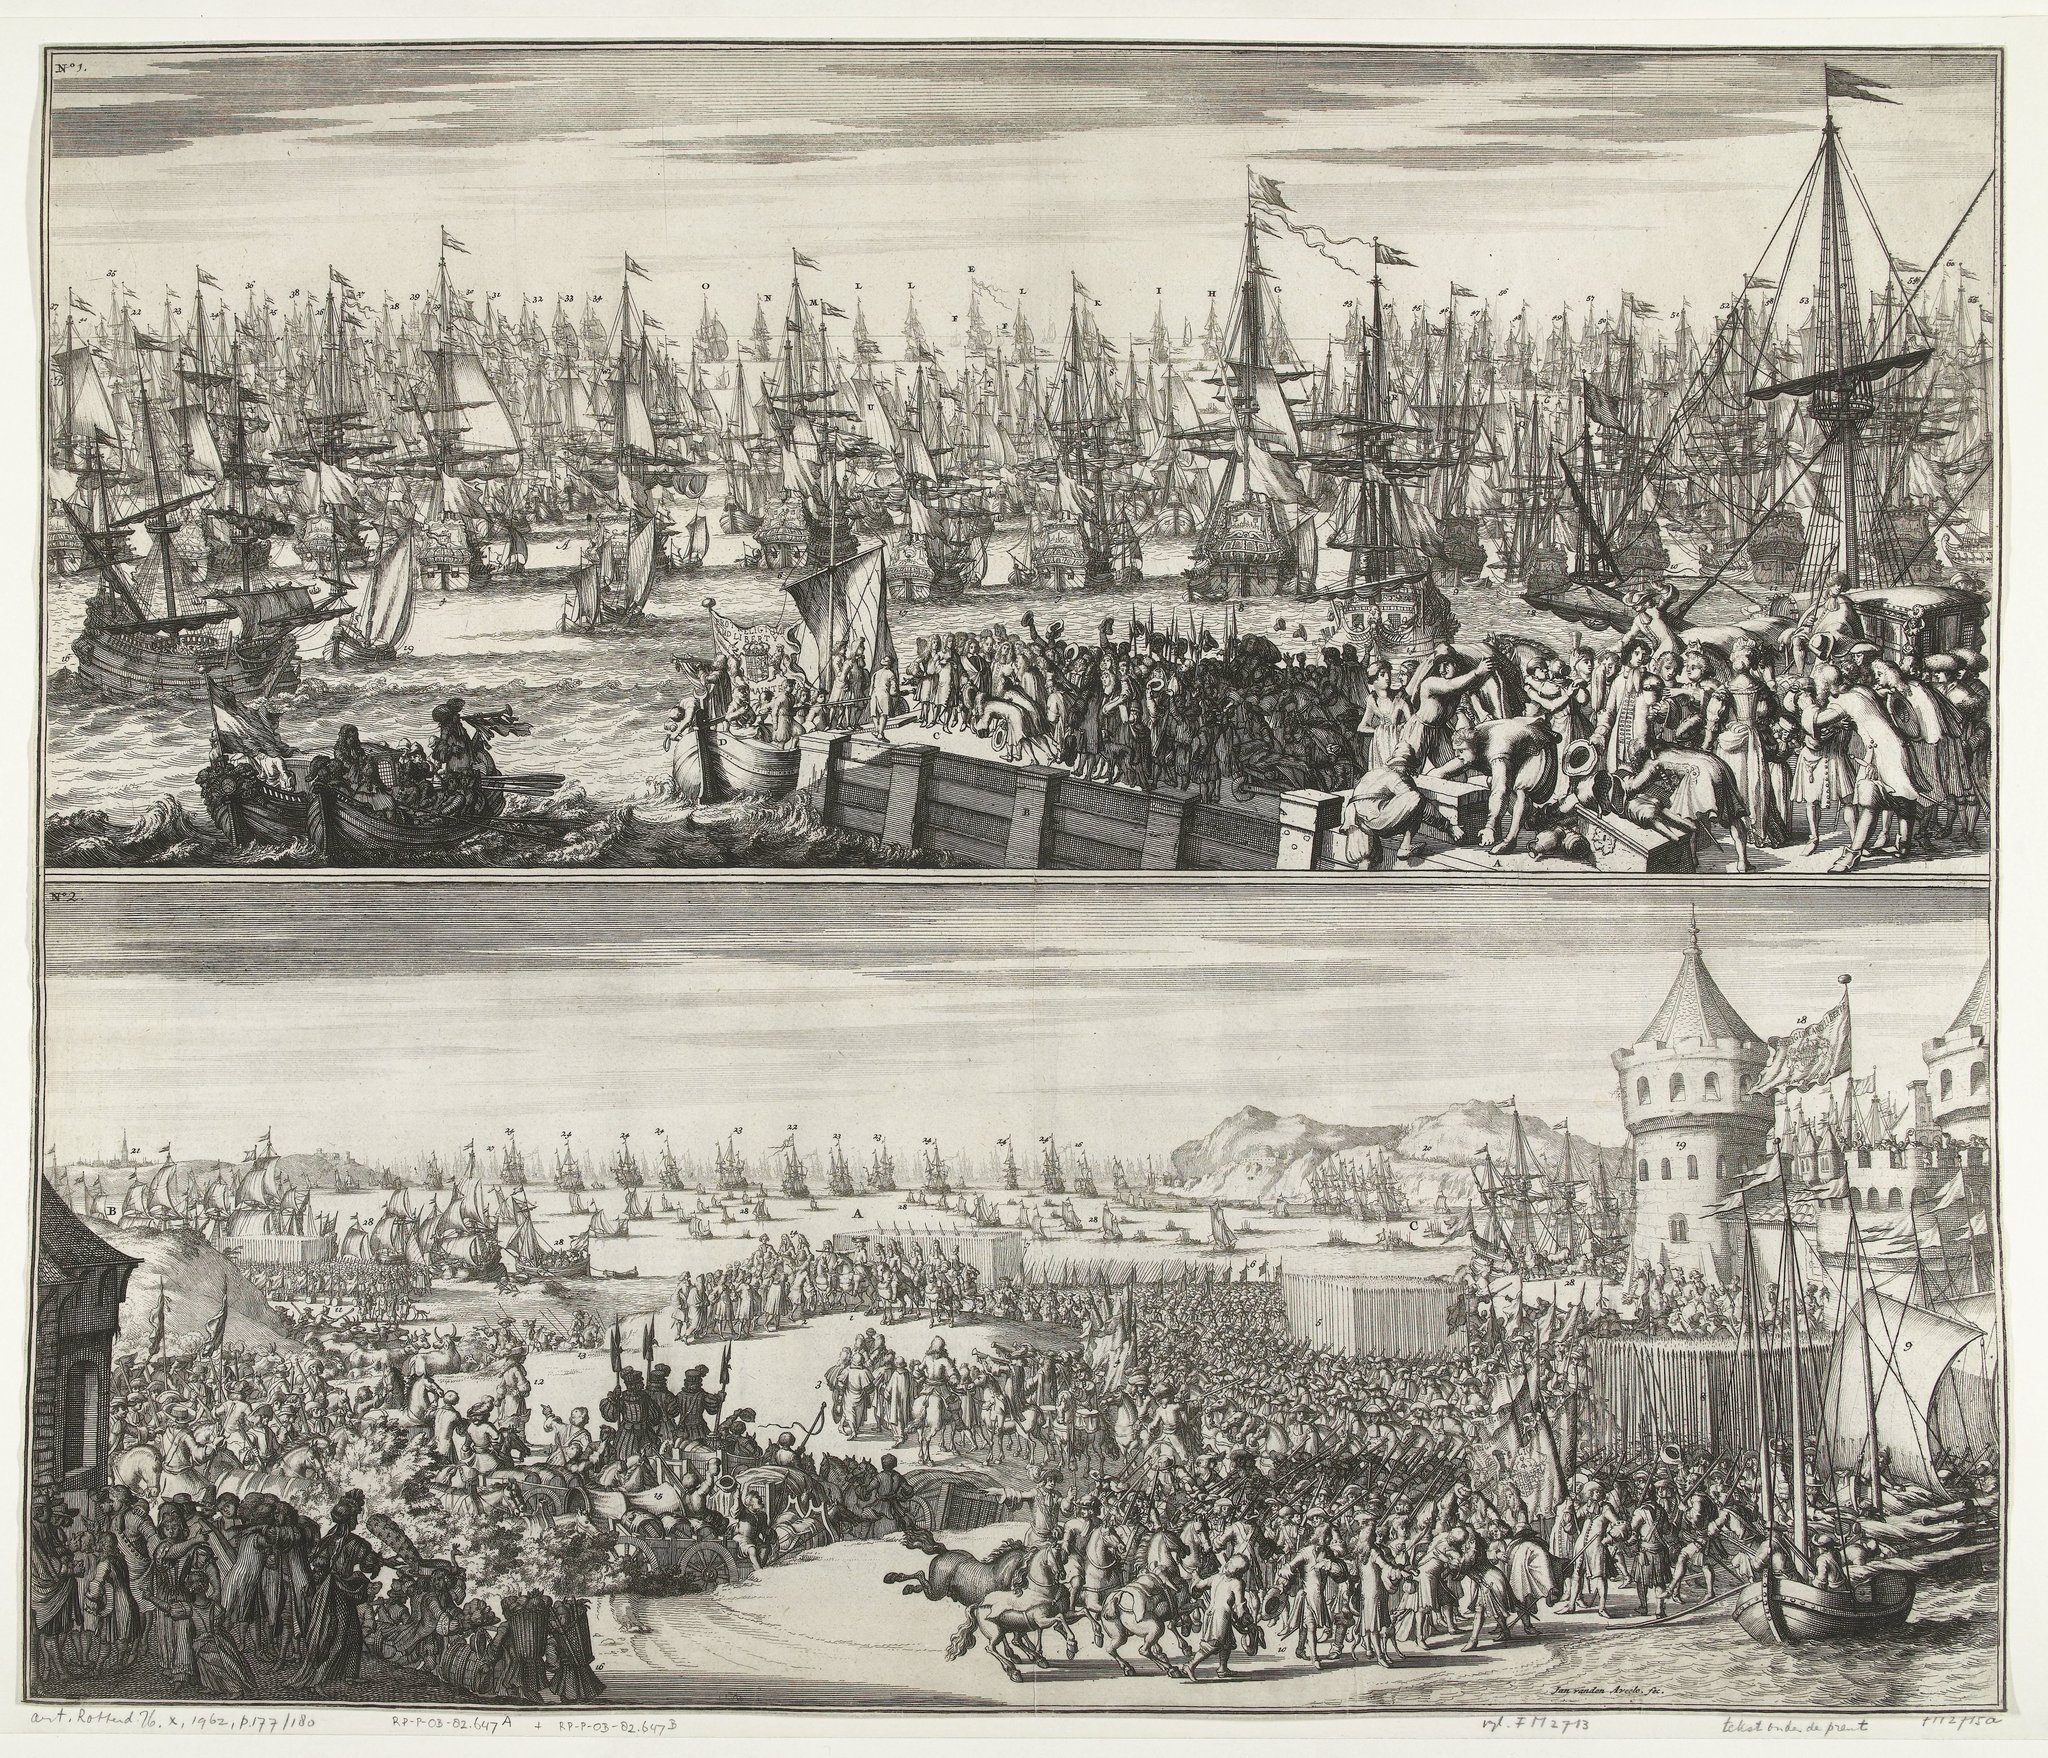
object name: print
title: Vertrek van Willem III naar Engeland en aankomst aldaar, 1688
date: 1689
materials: paper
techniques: etching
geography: amsterdam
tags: the hague, william iii (prince of orange and king of england, scotland, and ireland), arrival and return ~ travelling, departure ~ travelling, hellevoetsluis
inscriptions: date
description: Tocht van Willem III naar Engeland, 1688. Twee voorstellingen, genummerd 1 en 2. Boven: het vertek van Willem met zijn vloot op 11 november 1688 vanuit Hellevoetsluis. Volle kade en overzicht van de schepen. Onder de aankomst van de vloot van de prins in Torbay bij Brixham, 15 en 16 november 1688. Op de voorgrond gaat de prins aan land. Bij de prent behoort een tekstblad.